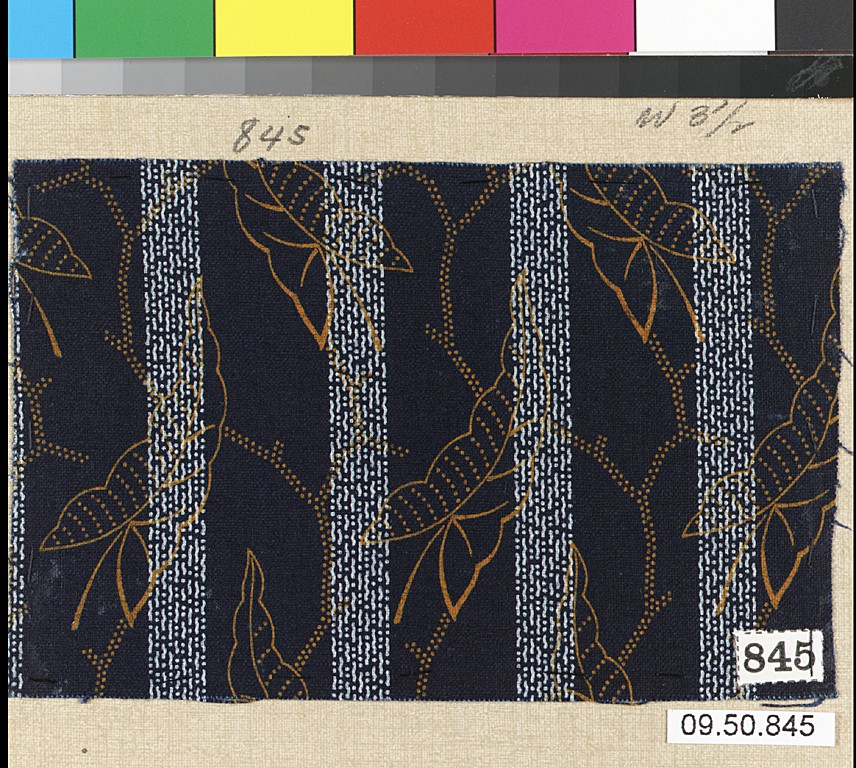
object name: piece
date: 1801-1900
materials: cotton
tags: butterflies